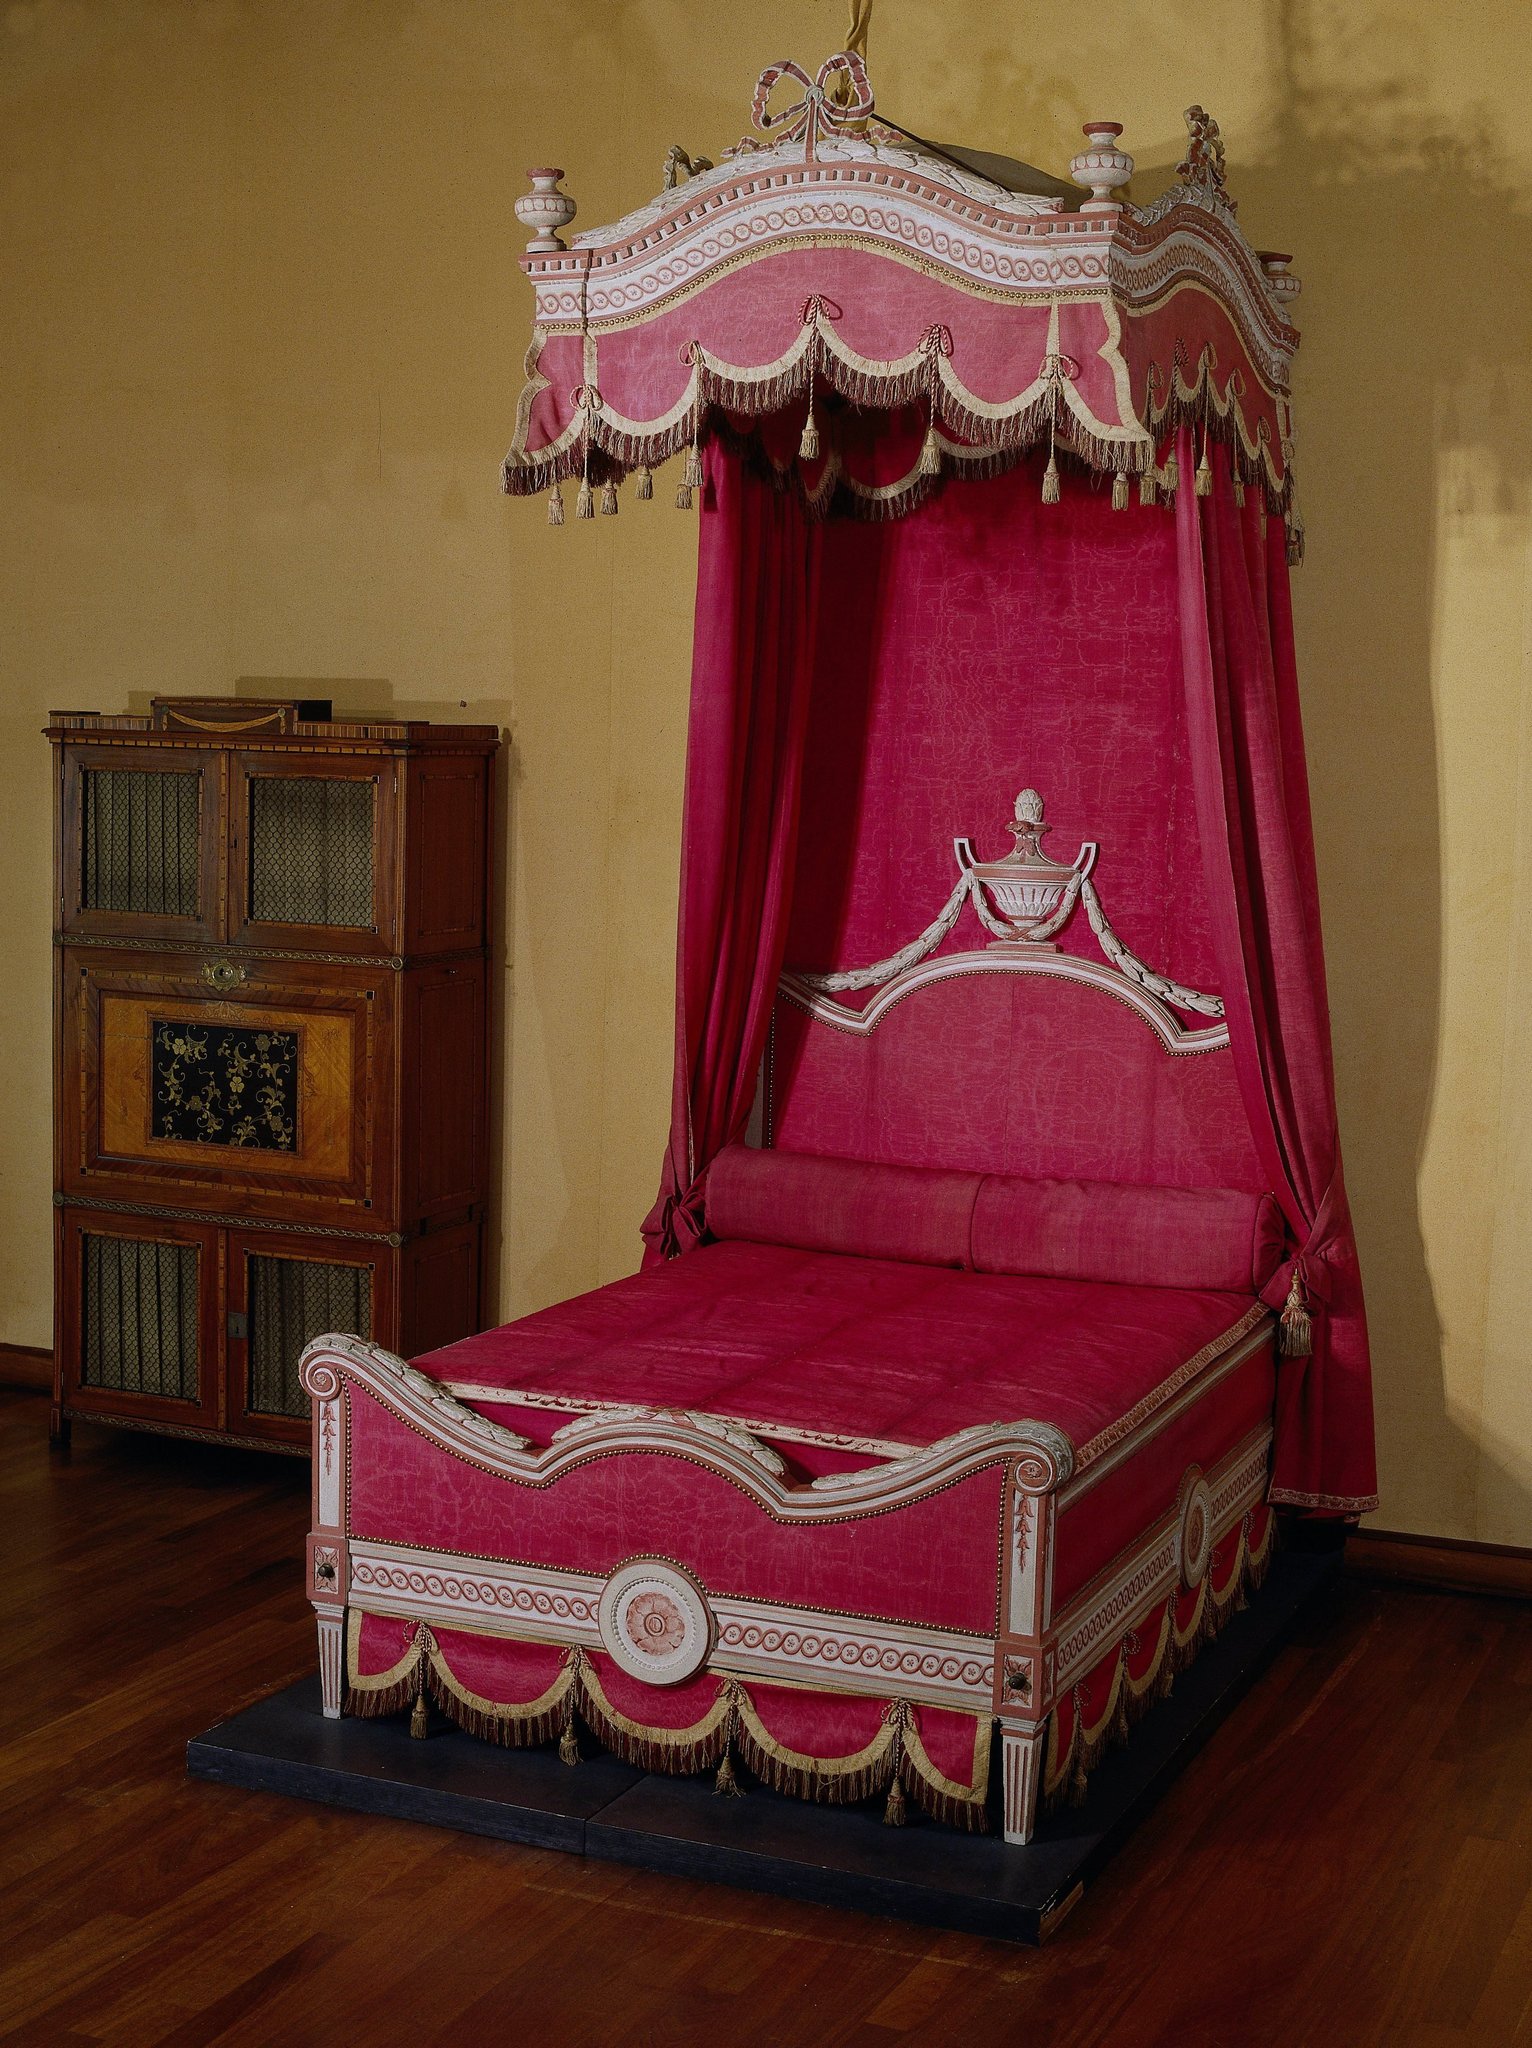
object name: bed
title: Canopy Bed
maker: Anonymous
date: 1775-1800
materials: cardboard, iron, wood, linen, paint, silk, wool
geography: netherlands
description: Following French fashion, Dutch furniture makers began making various sorts of canopy beds in the 18th century. This type was known as a lit à la française, even though the proportions do not entirely agree. An important feature is that the canopy had to be hung from the ceiling. The bed probably belonged to the De la Court family and came from Onsenoort mansion in Nieuwkuijk.